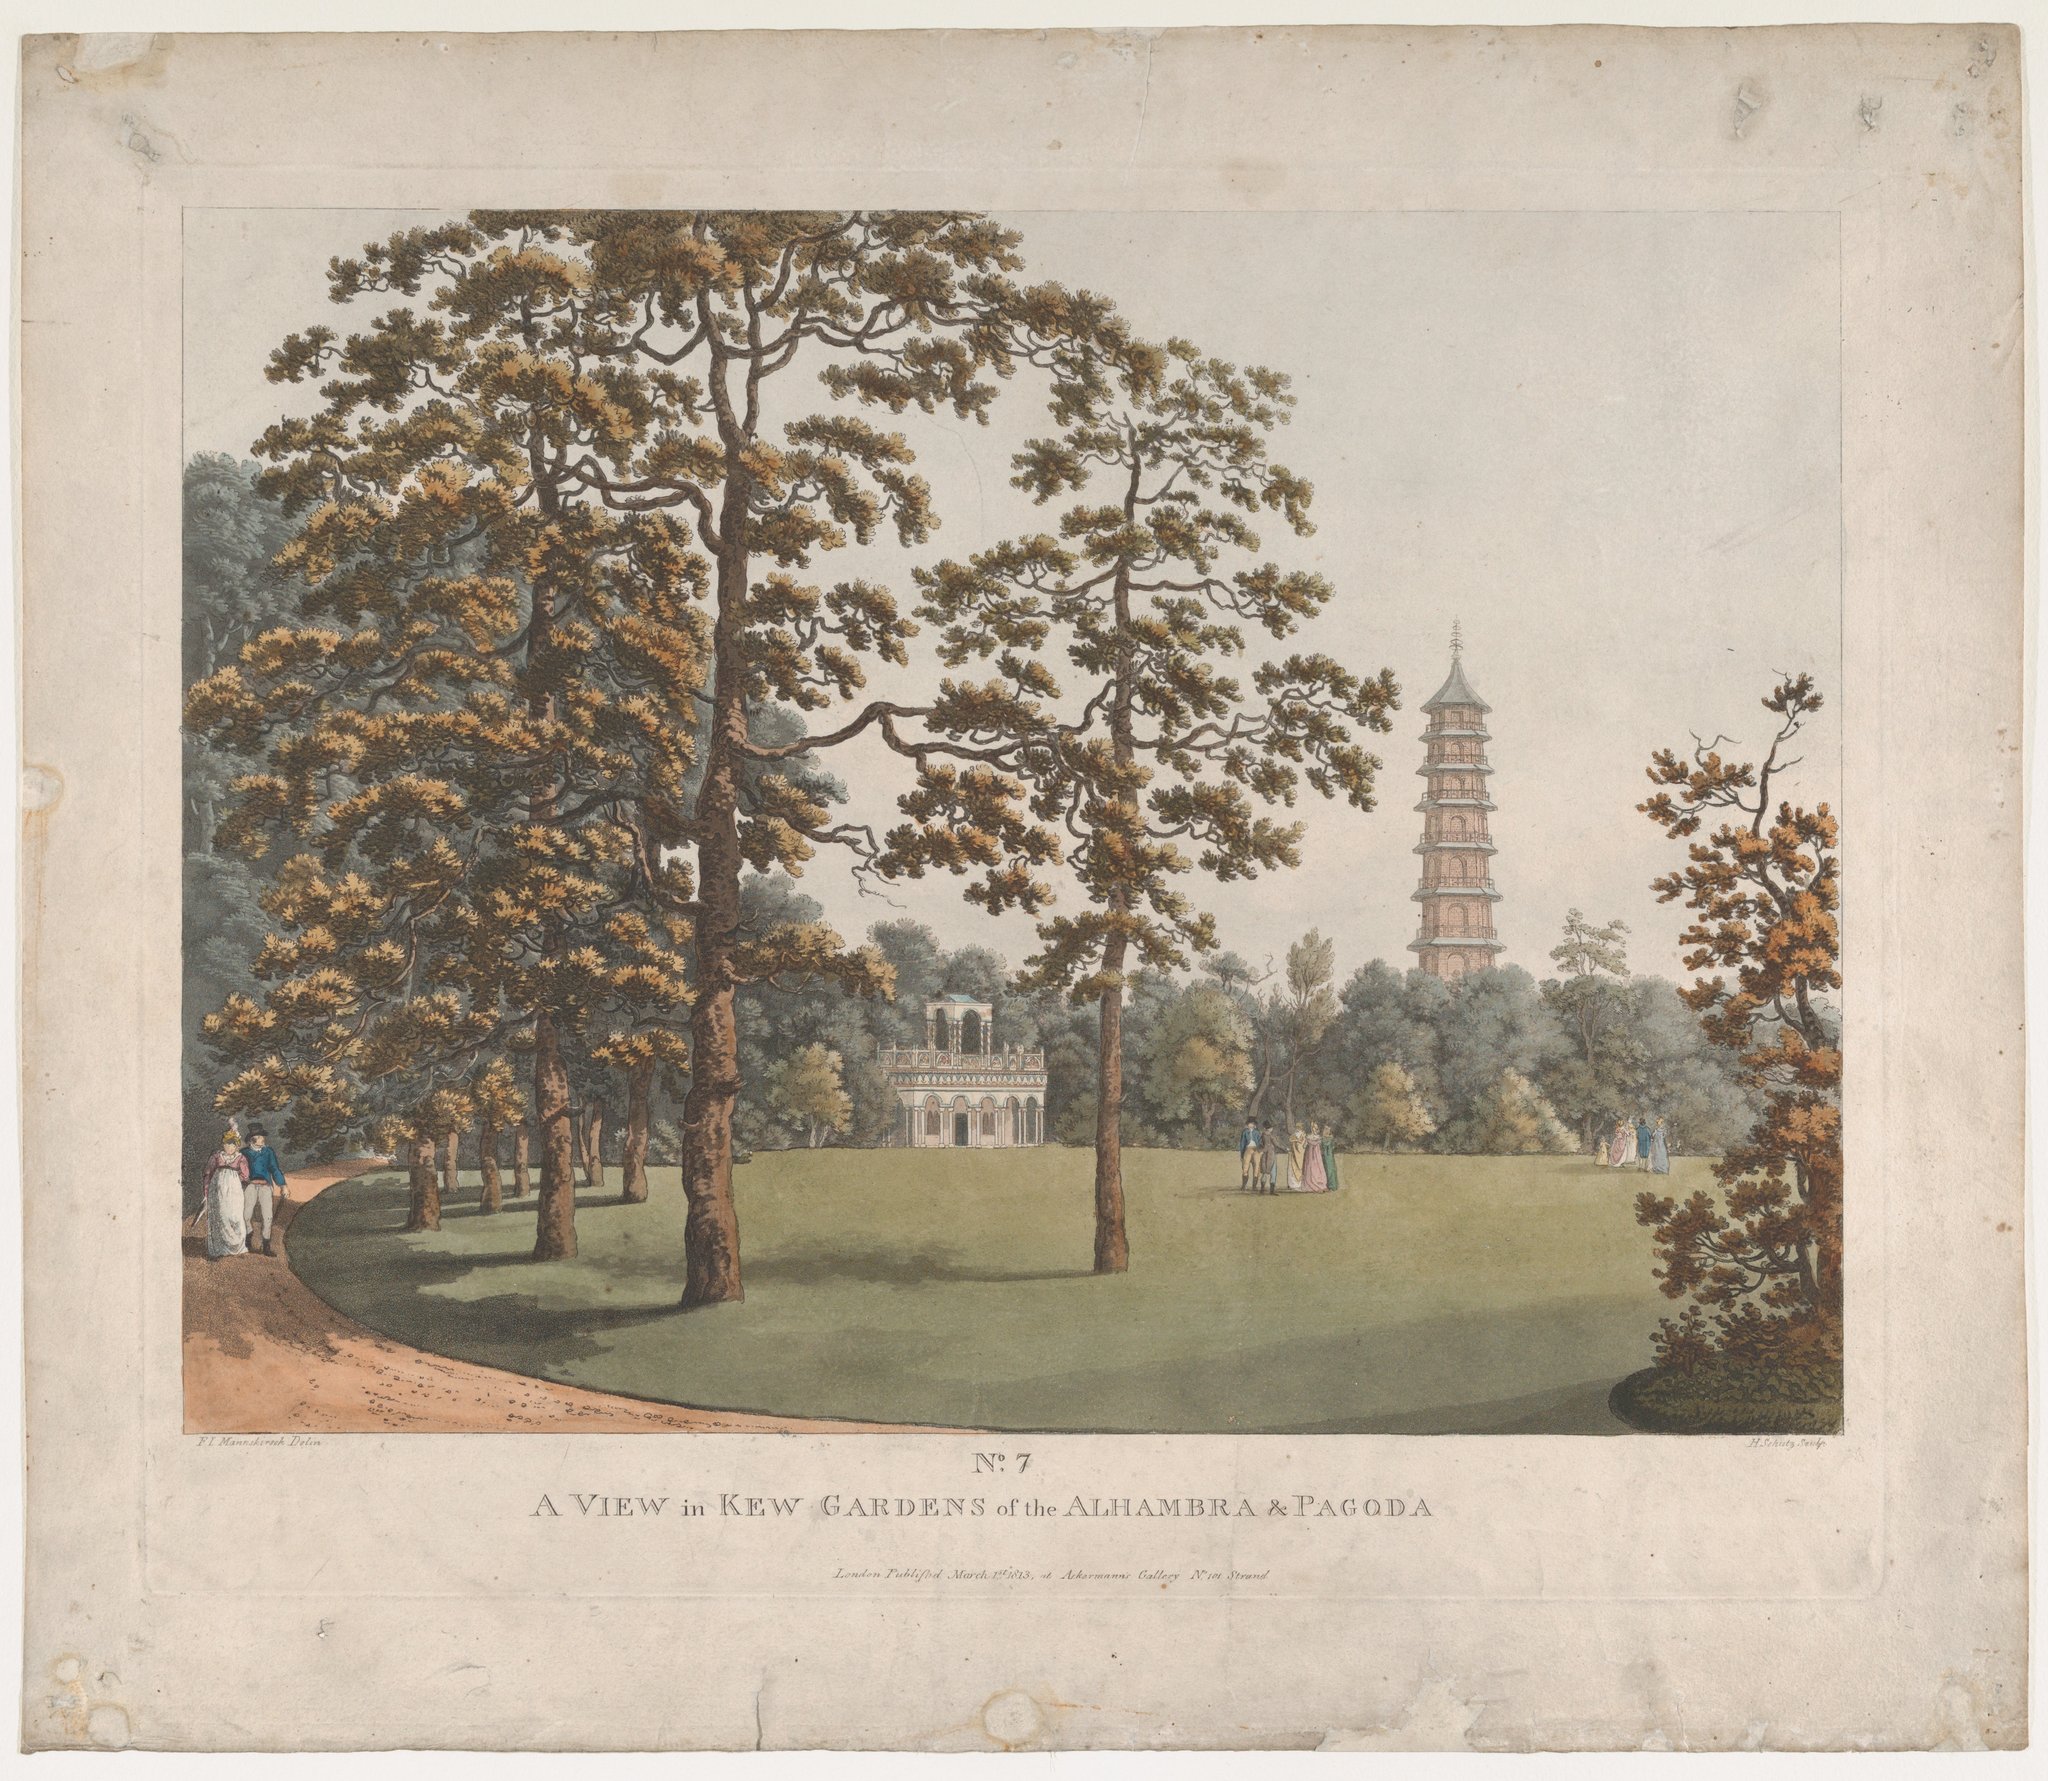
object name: print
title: A View in Kew Gardens of the Alhambra and the Pagoda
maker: heinrich joseph schütz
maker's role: artist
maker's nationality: german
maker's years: 1800-1825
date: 1813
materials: watercolor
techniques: aquatint